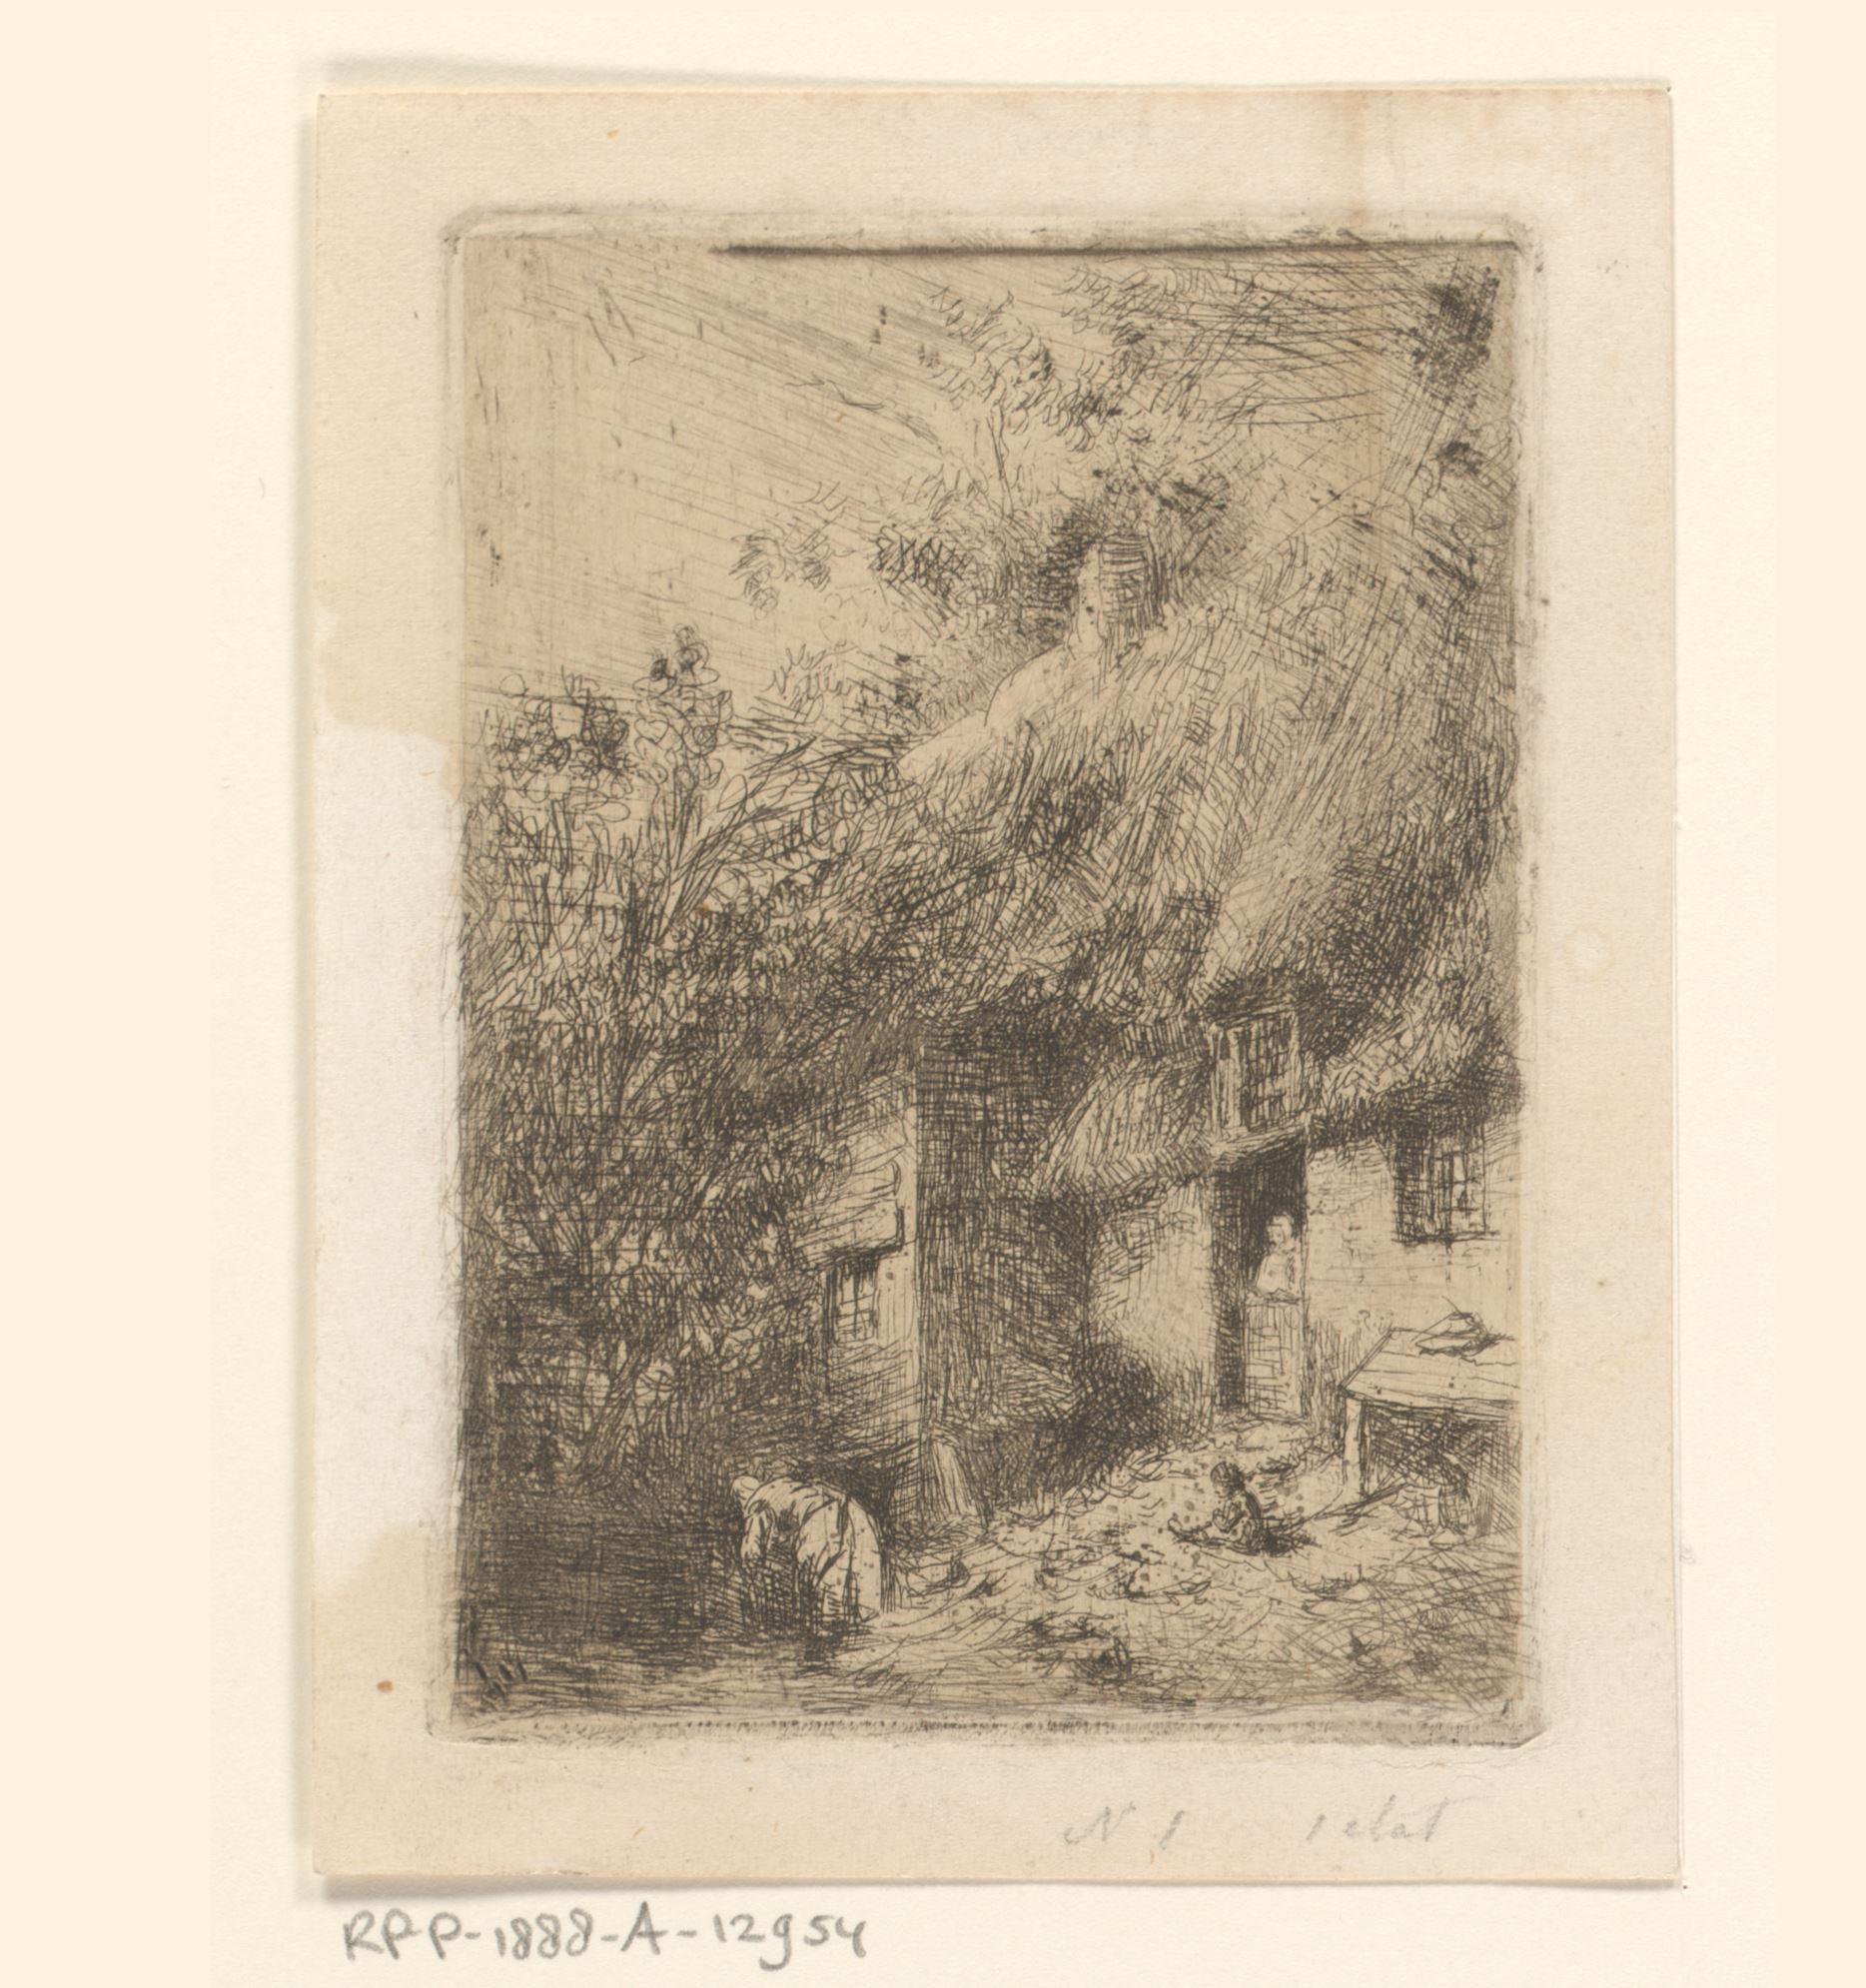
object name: print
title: Boerenerf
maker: henri de braekeleer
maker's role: draughtsman, print maker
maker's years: 1840-1888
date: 1850-1870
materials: paper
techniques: etching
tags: courtyard, farm (building)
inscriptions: collector's mark: Lugt 2228